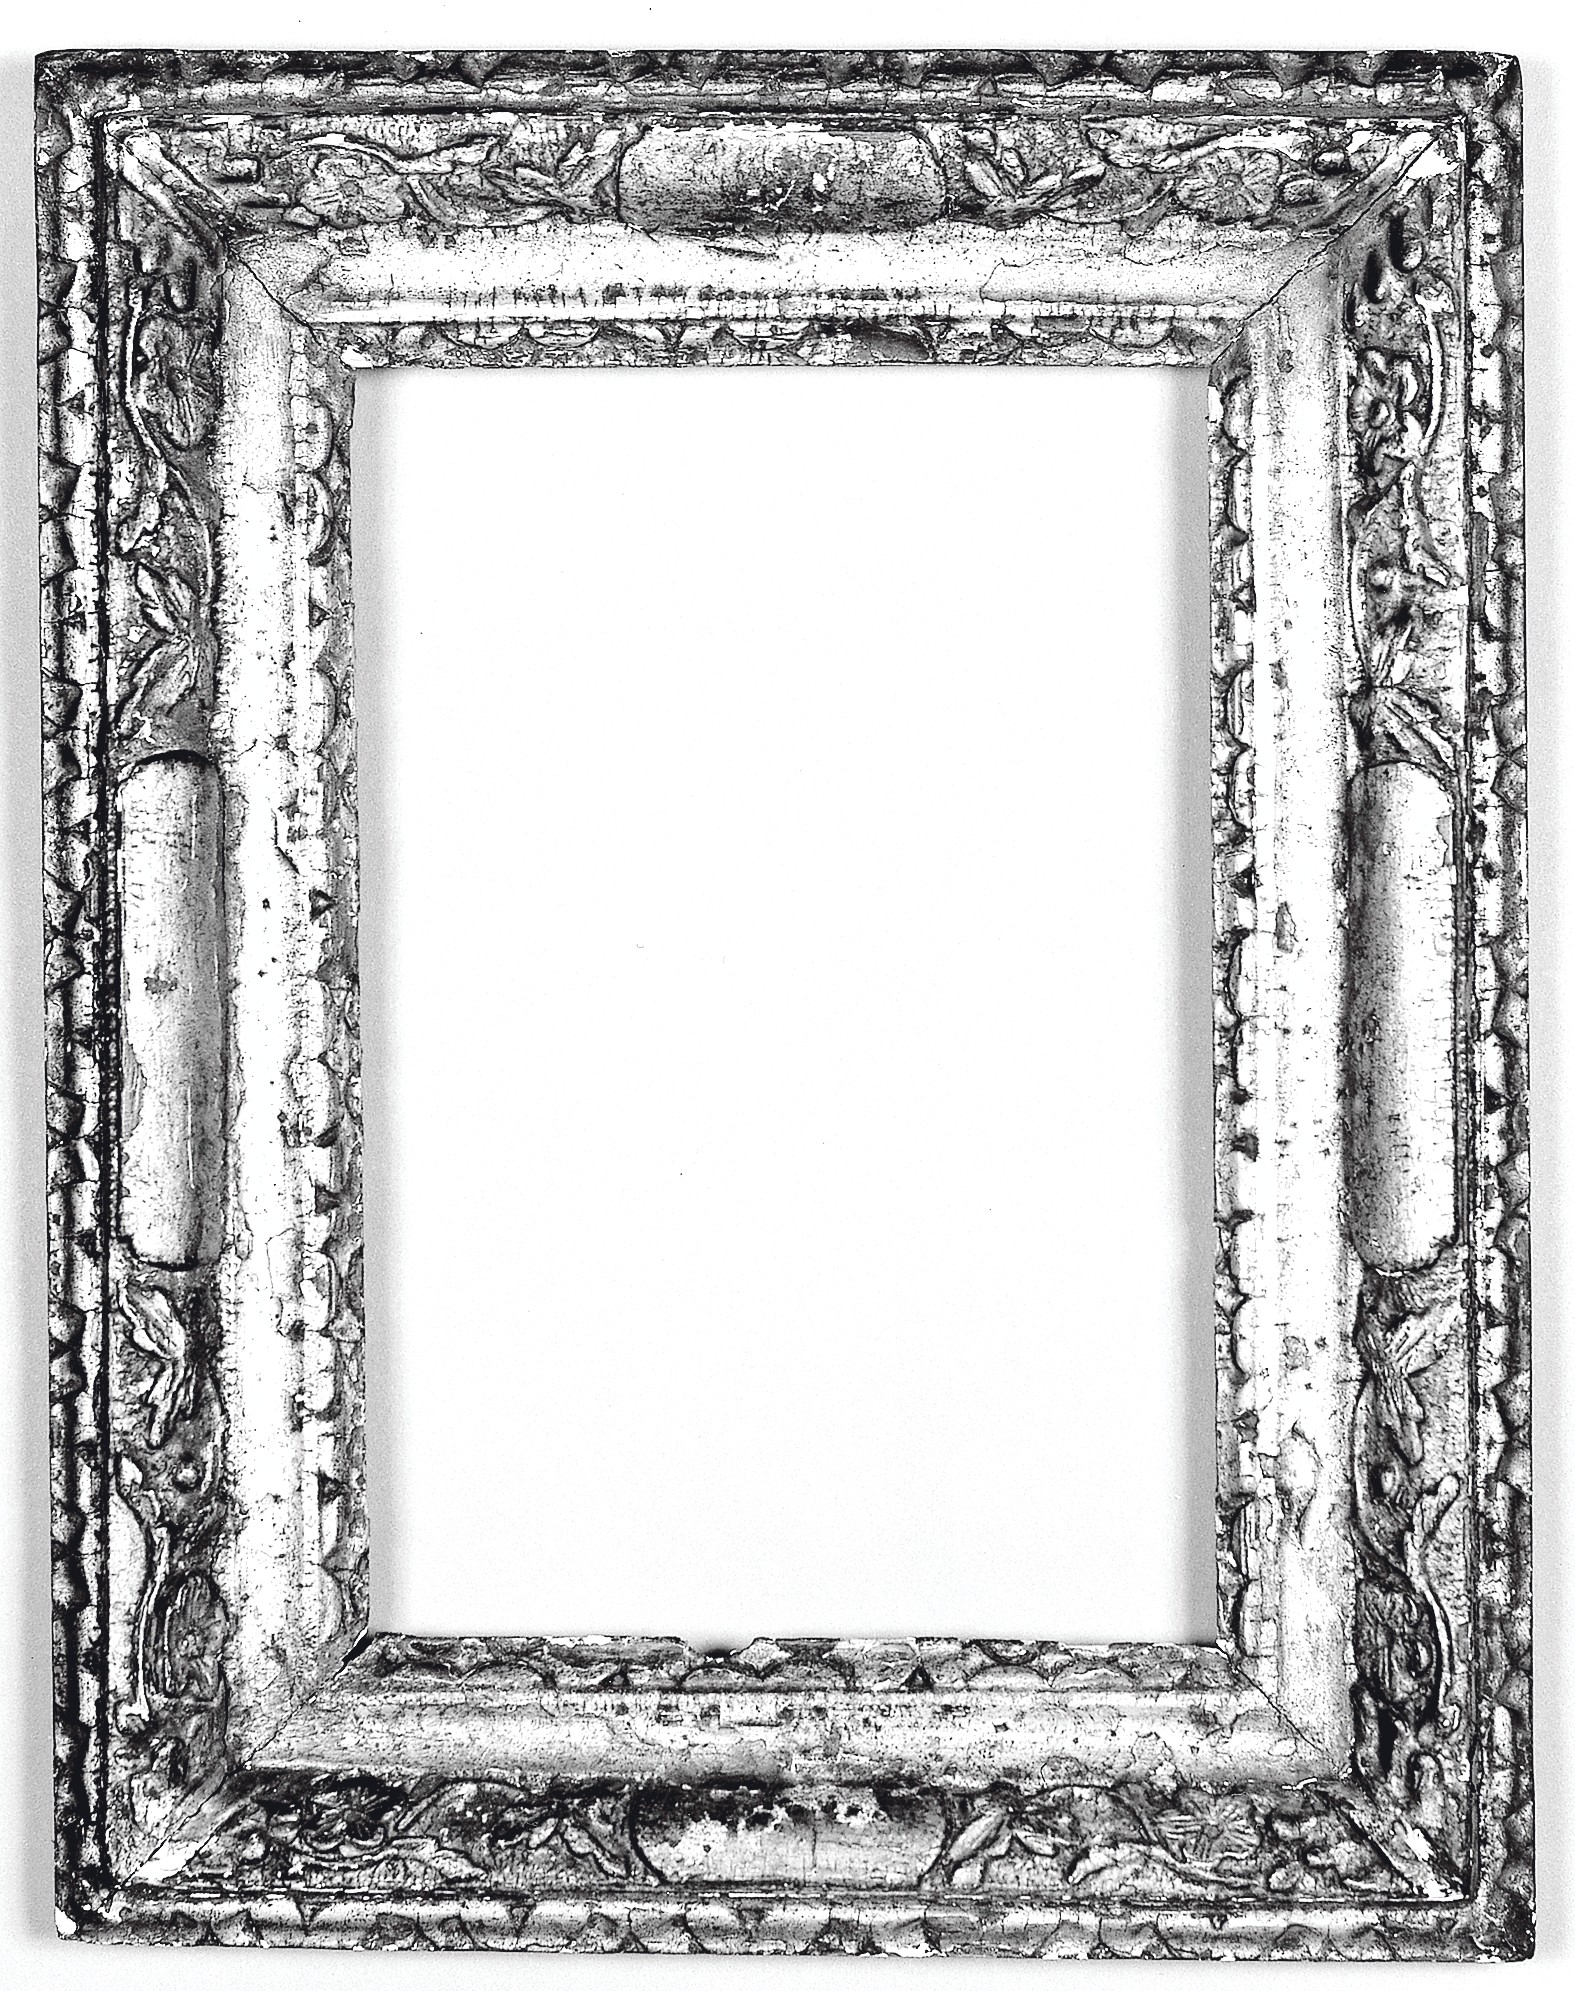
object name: frame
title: Lely frame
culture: british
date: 1700-1710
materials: wood